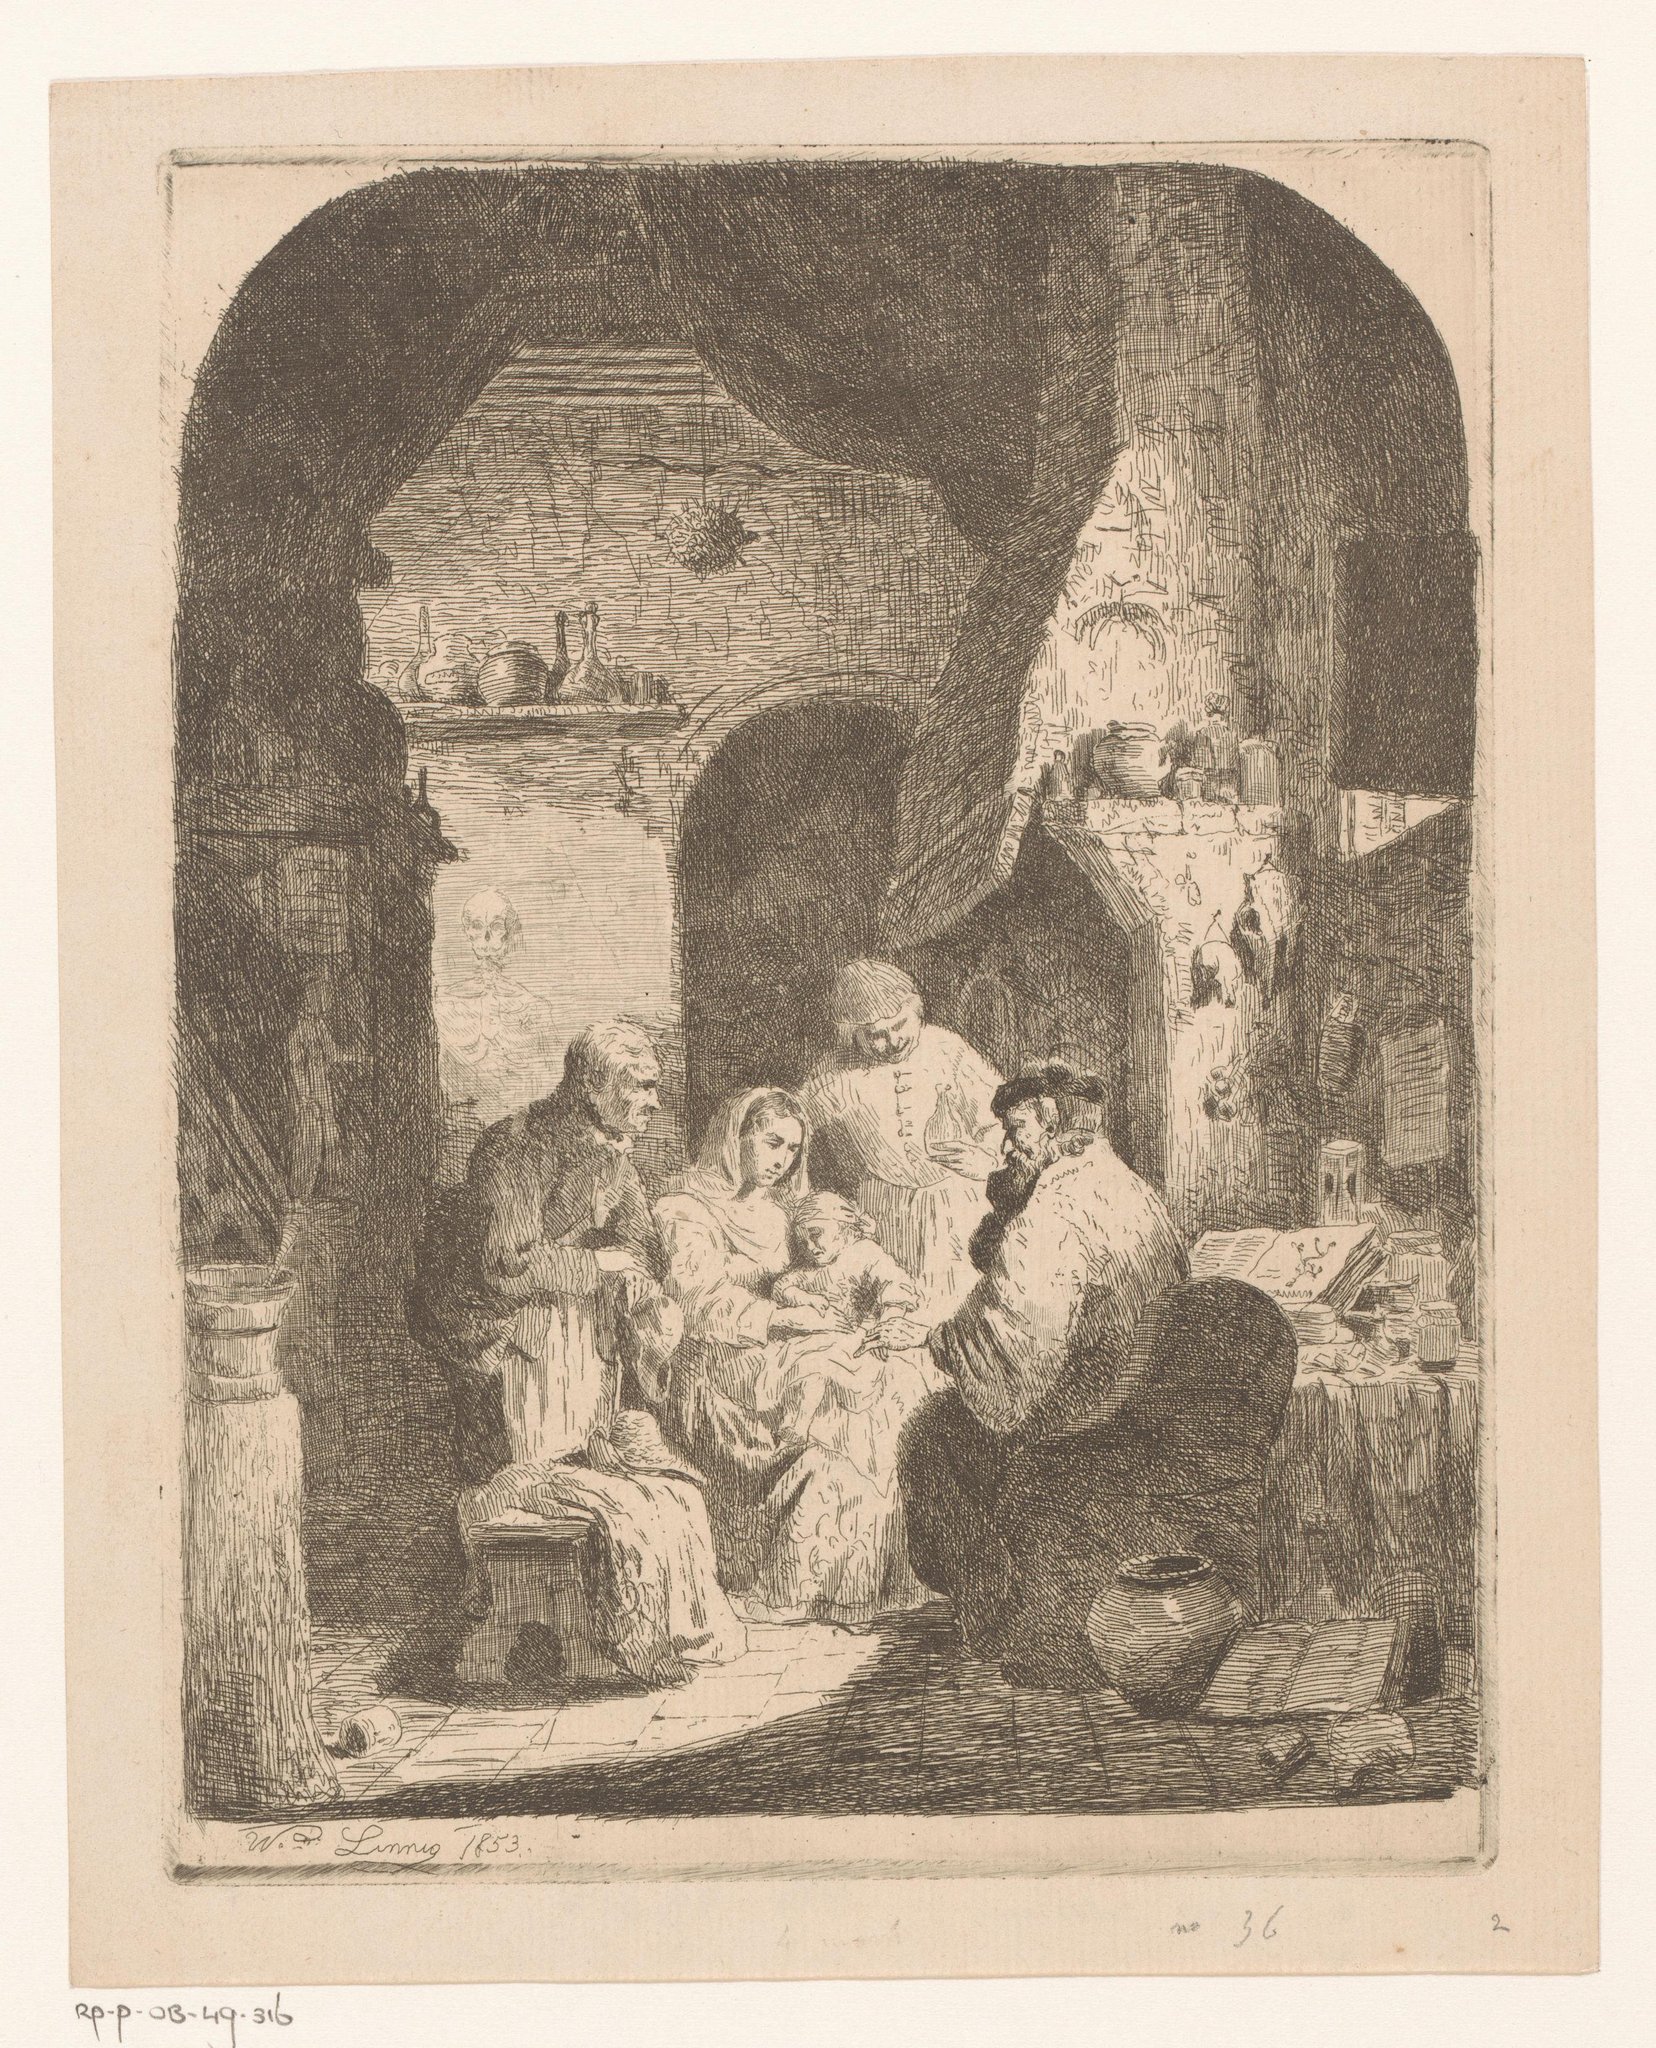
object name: print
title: Gezin met een ziek kind bij de dokter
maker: willem linnig (i)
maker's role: print maker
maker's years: 1819-1885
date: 1853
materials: paper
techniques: etching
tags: physician, doctor, hourglass, (human) skeleton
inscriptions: collector's mark: Lugt 2228, annotation: ‘zeer zeldzaam’